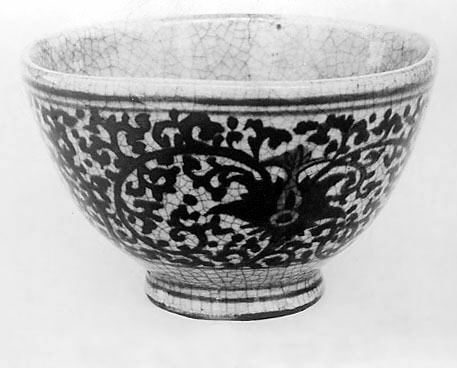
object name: bowl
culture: japanese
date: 1701-1800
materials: clay, glaze